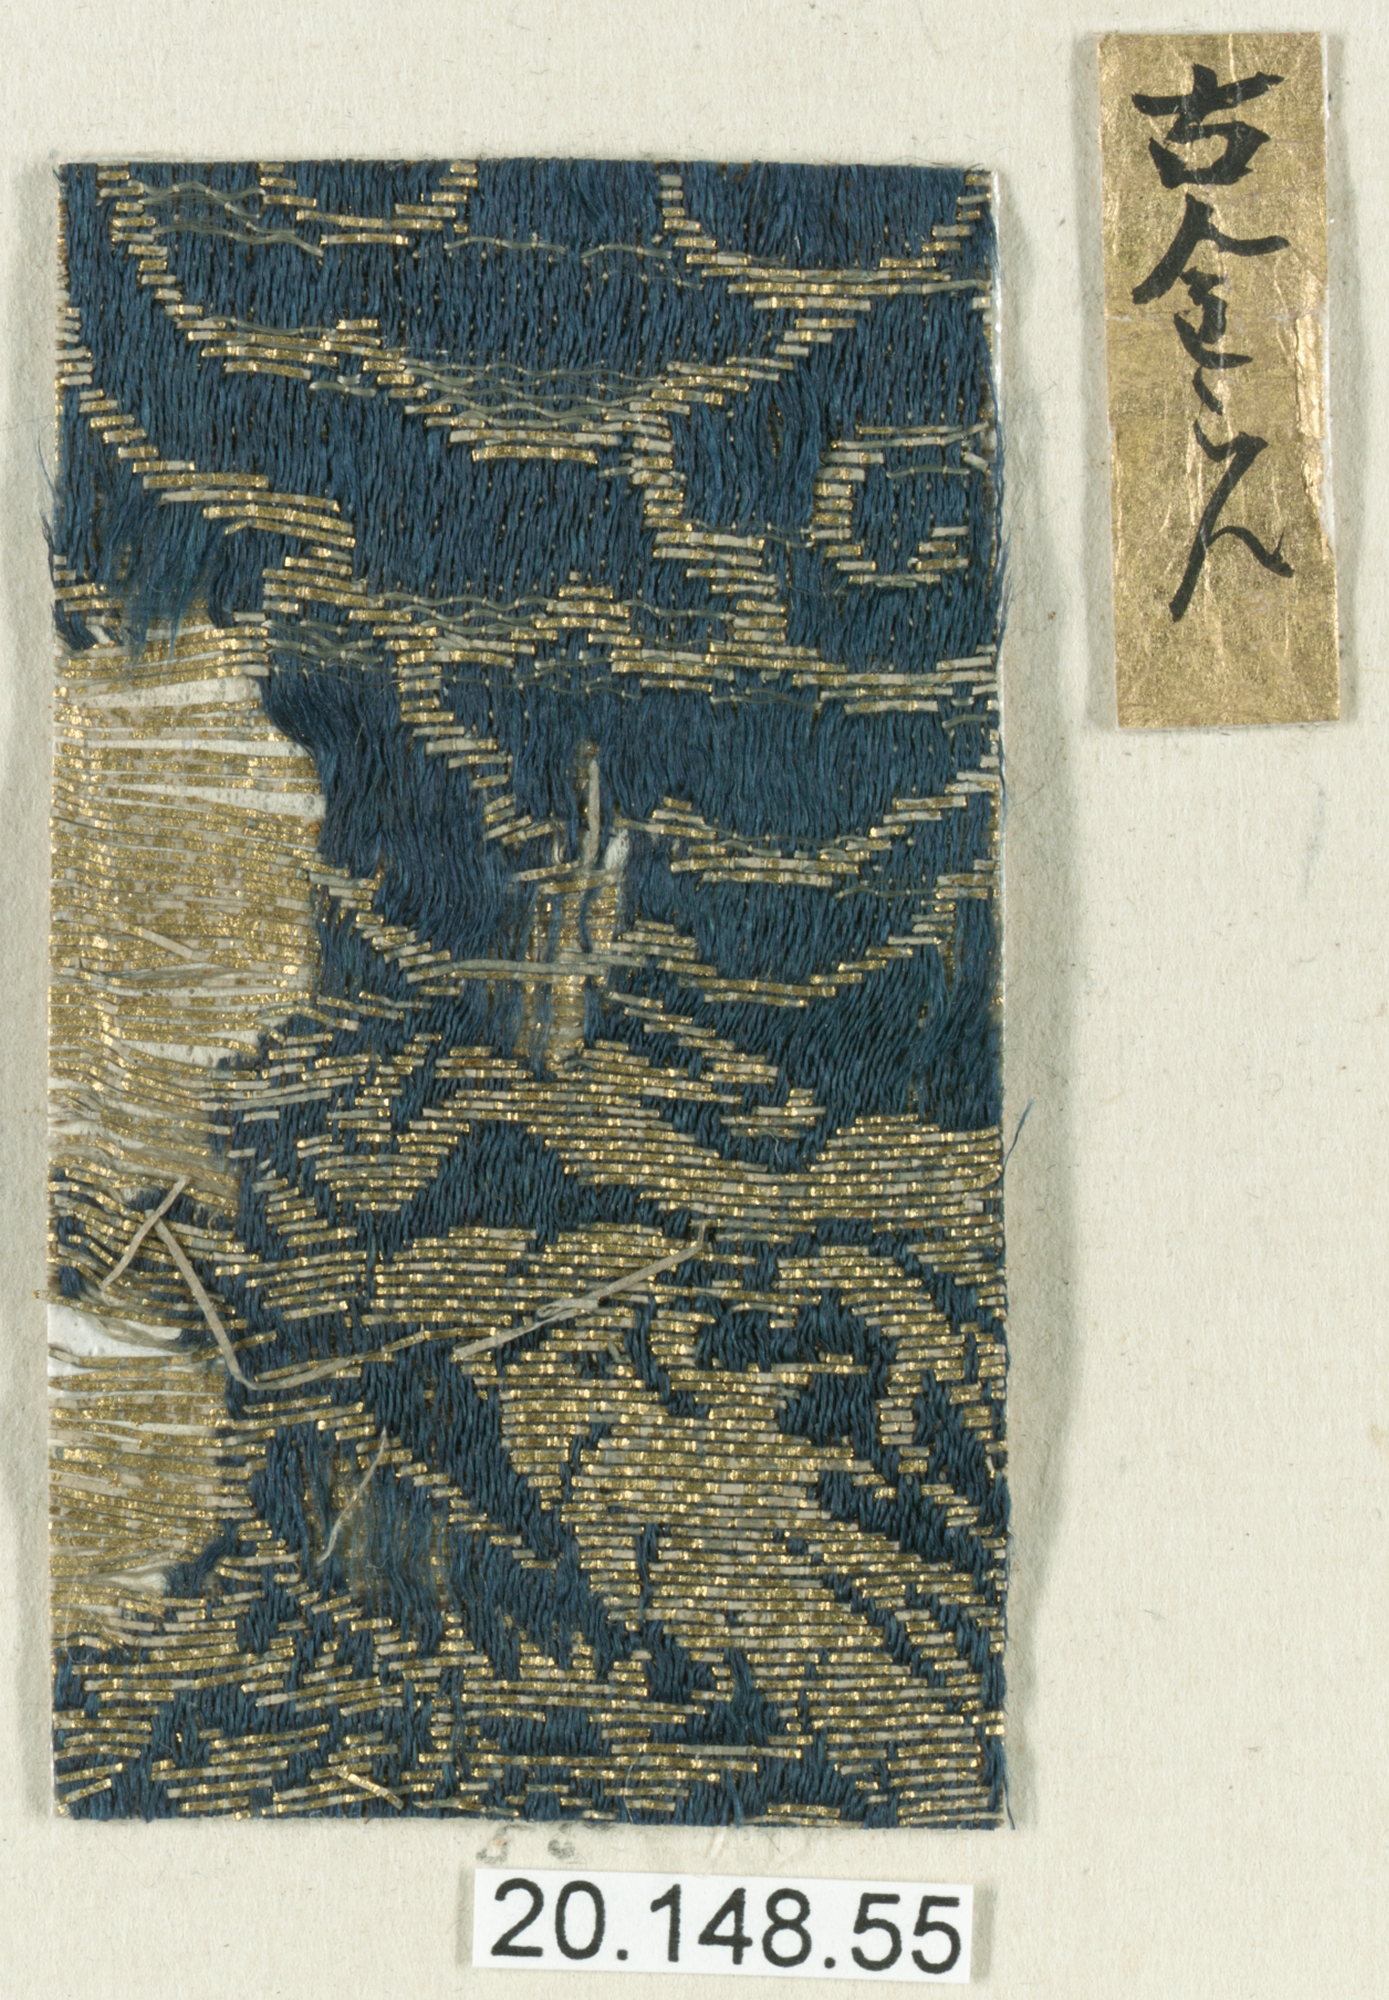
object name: piece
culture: japanese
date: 1501-1600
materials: silk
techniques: compound weave